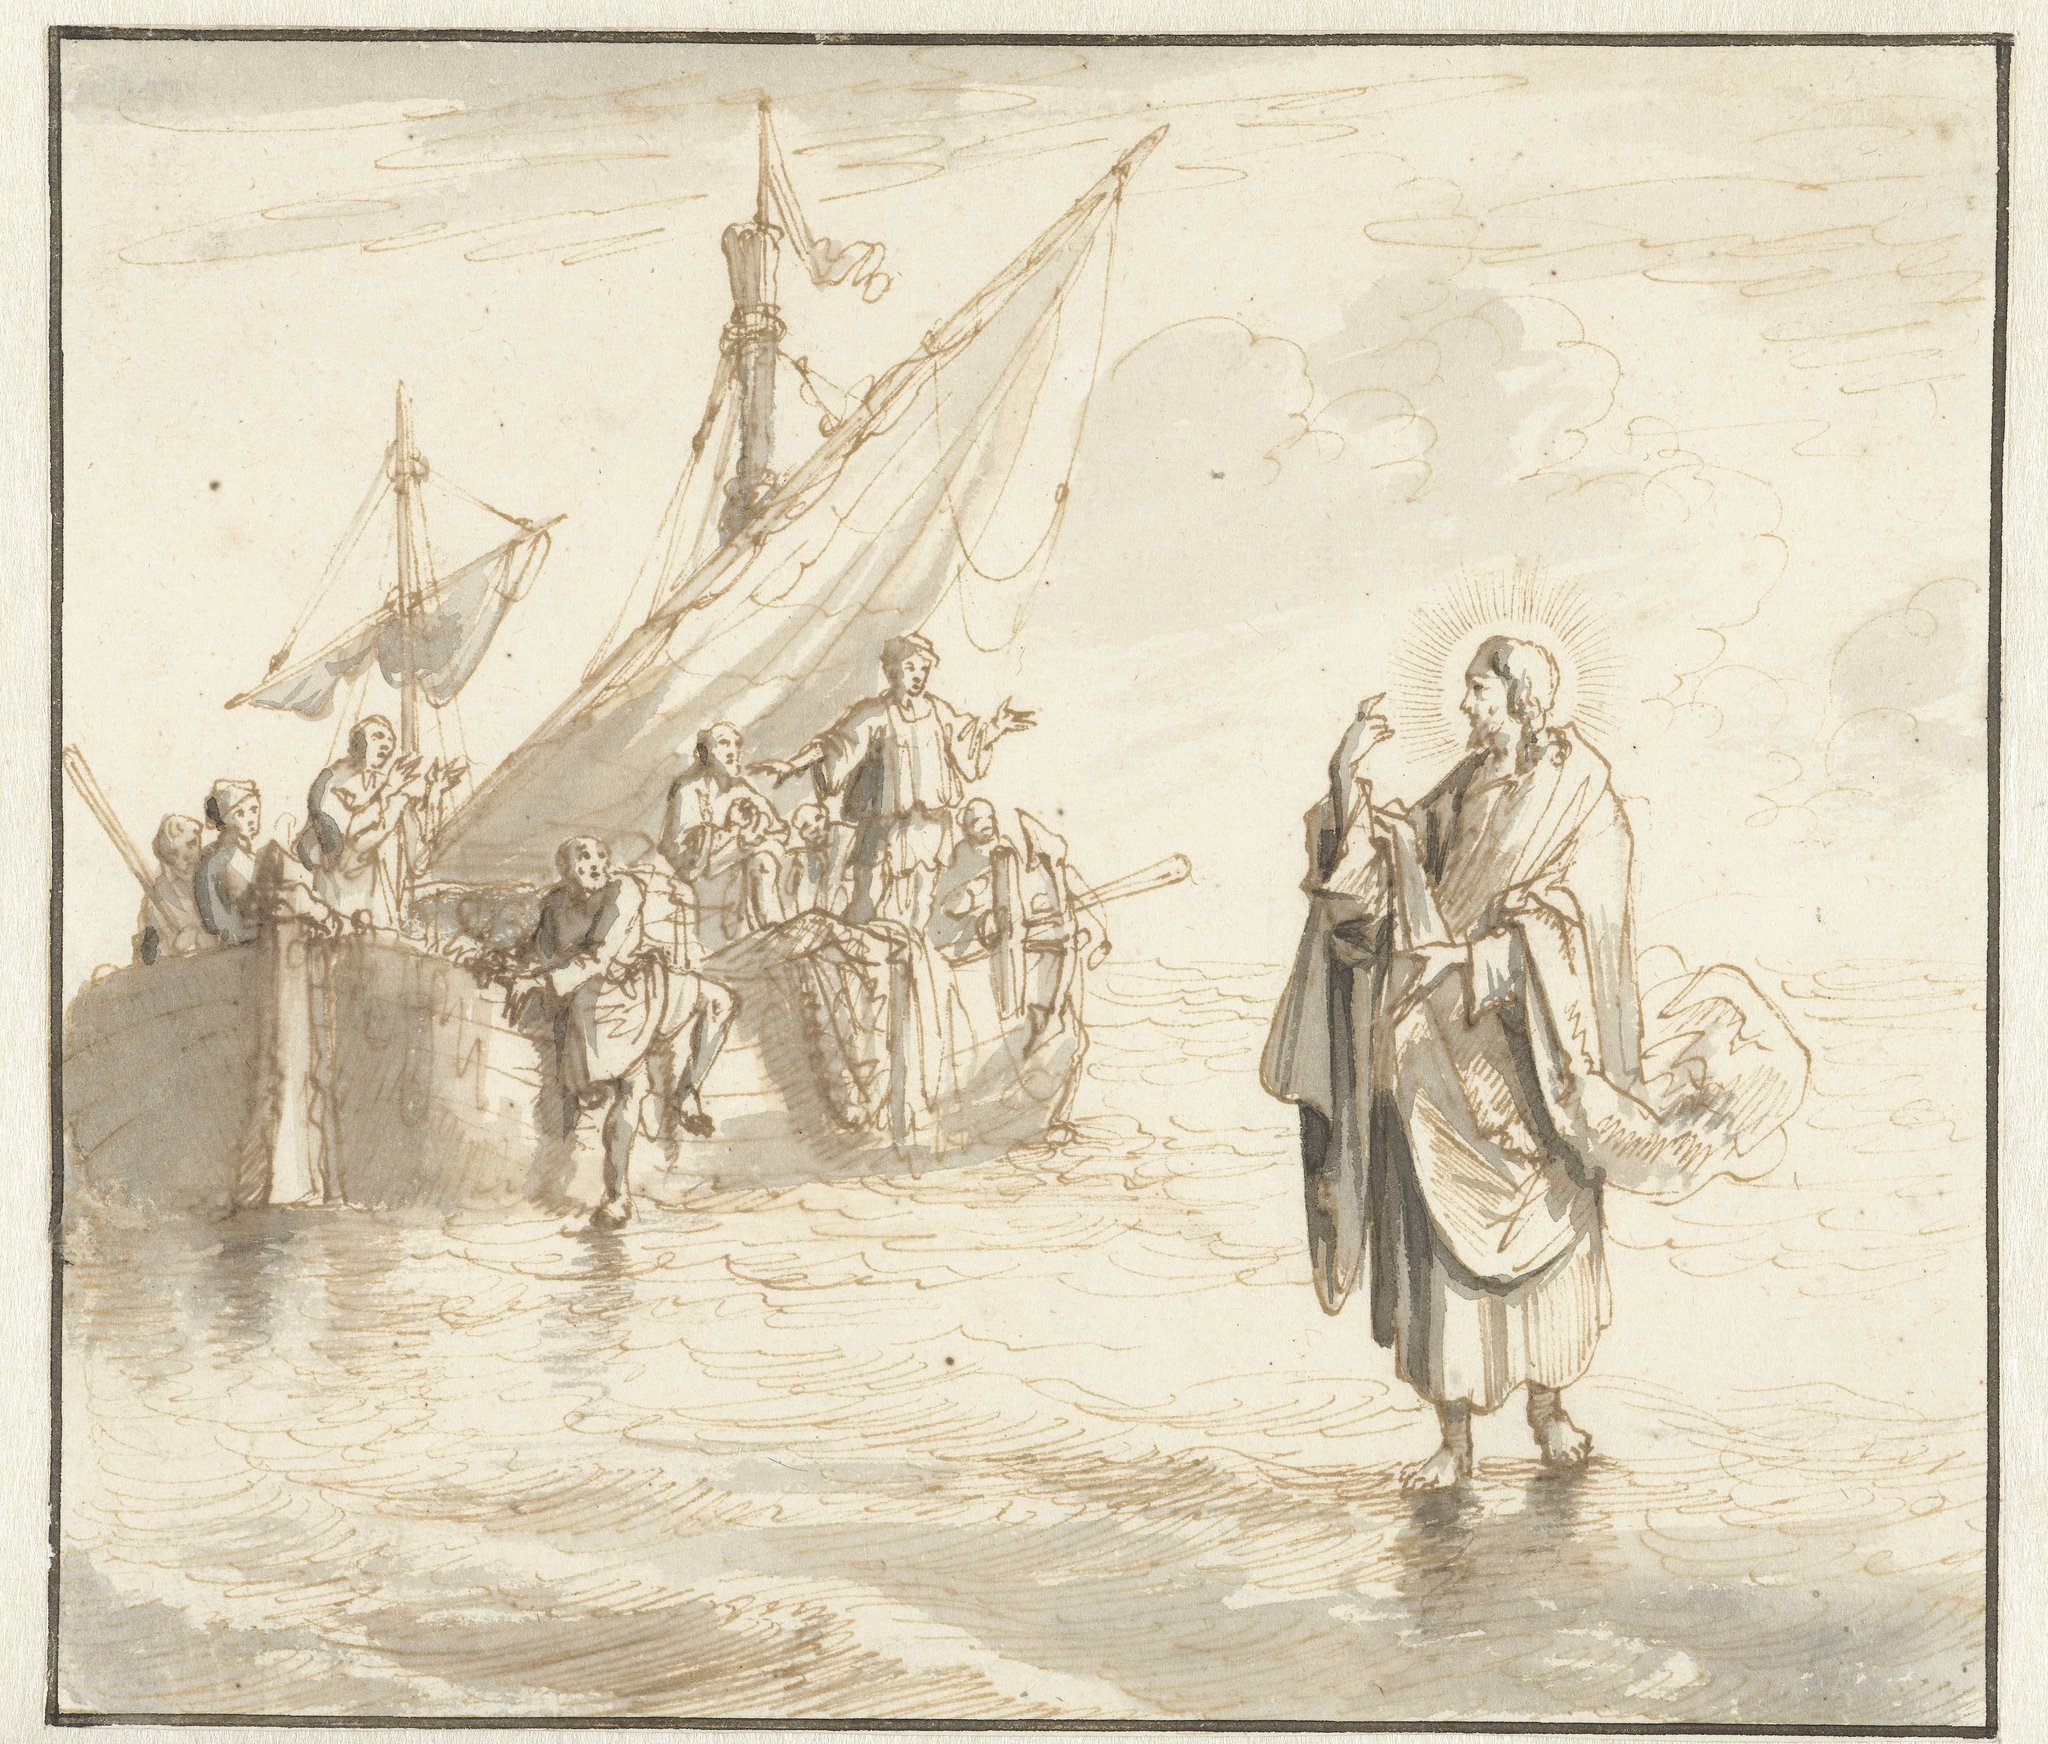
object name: design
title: Christus loopt op het water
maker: jan luyken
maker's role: draughtsman, print maker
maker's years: 1649-1712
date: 1660-1712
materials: ink, paper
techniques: brush, pen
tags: peter steps out of the boat and tries to walk on the water towards christ